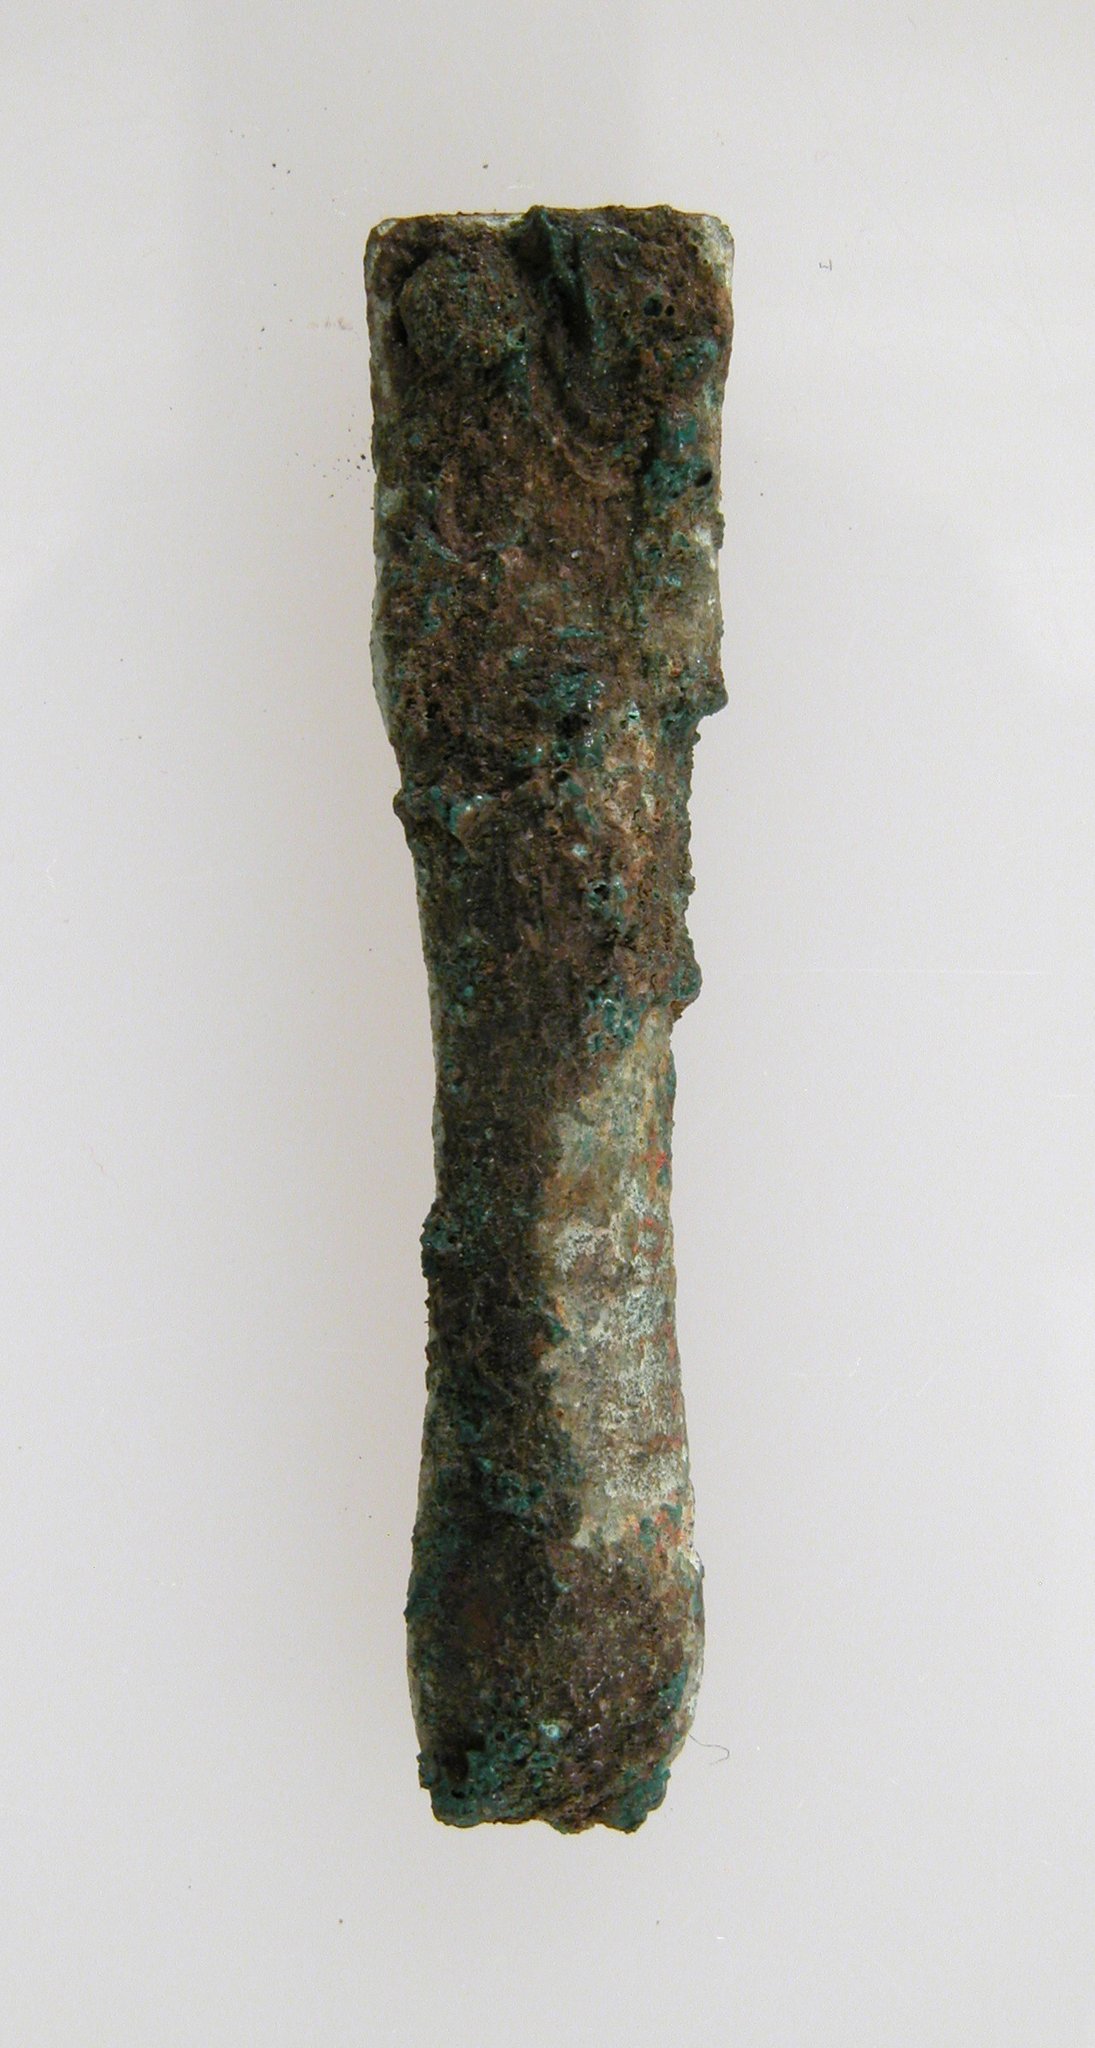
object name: ferret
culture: frankish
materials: copper alloy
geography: germany